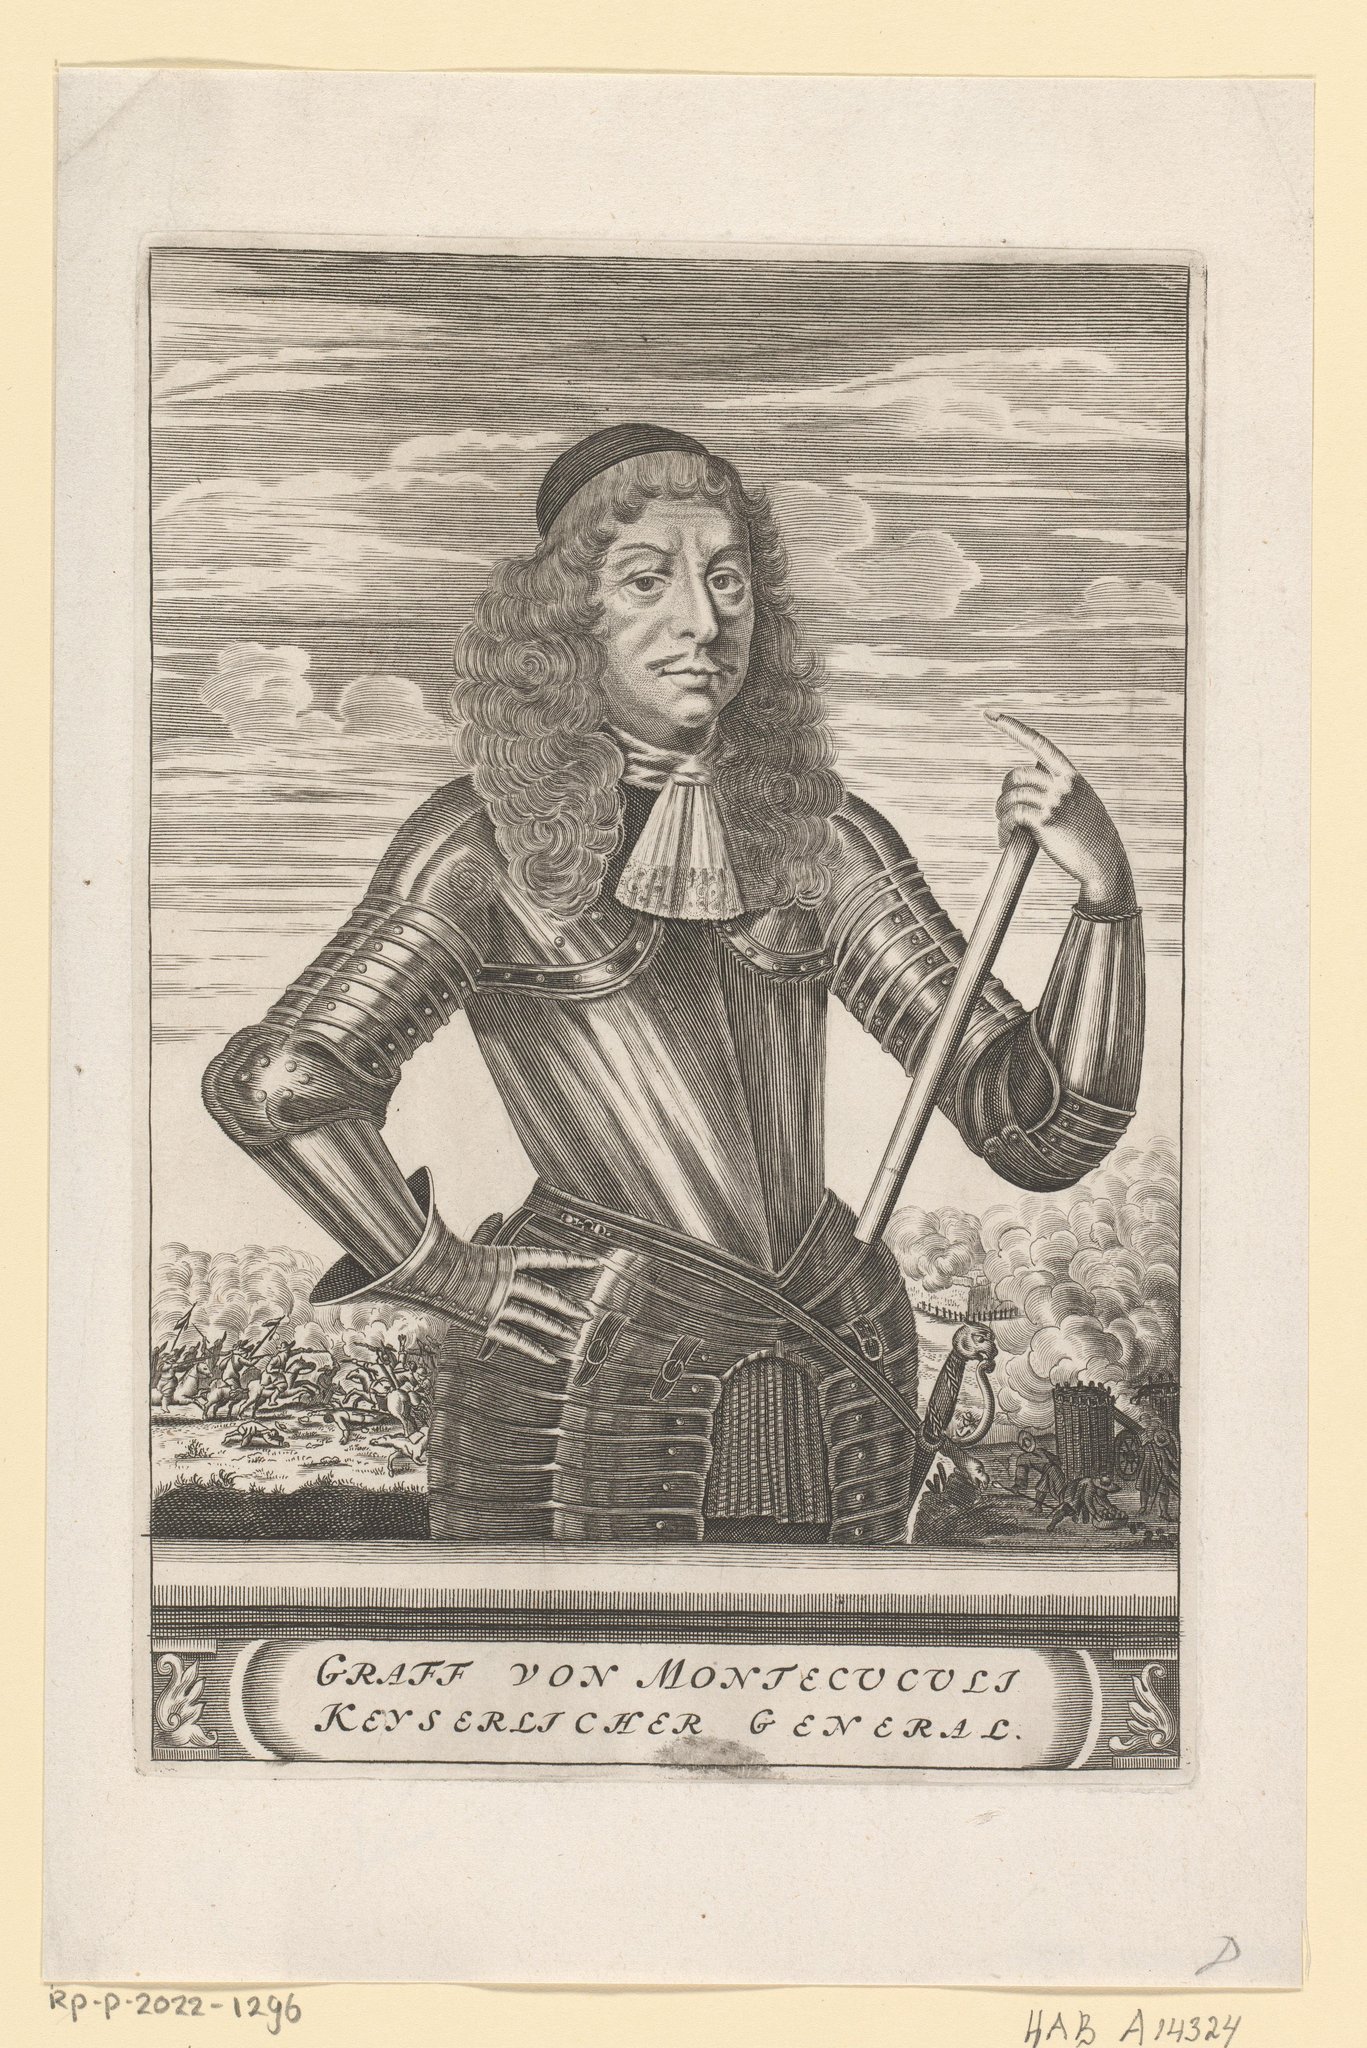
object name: print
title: Portret van Raimondo Montecuccoli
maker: christiaan hagen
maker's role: draughtsman, print maker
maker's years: 1635-1707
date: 1663-1695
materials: paper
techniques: engraving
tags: commander-in-chief, general, marshal, historical persons